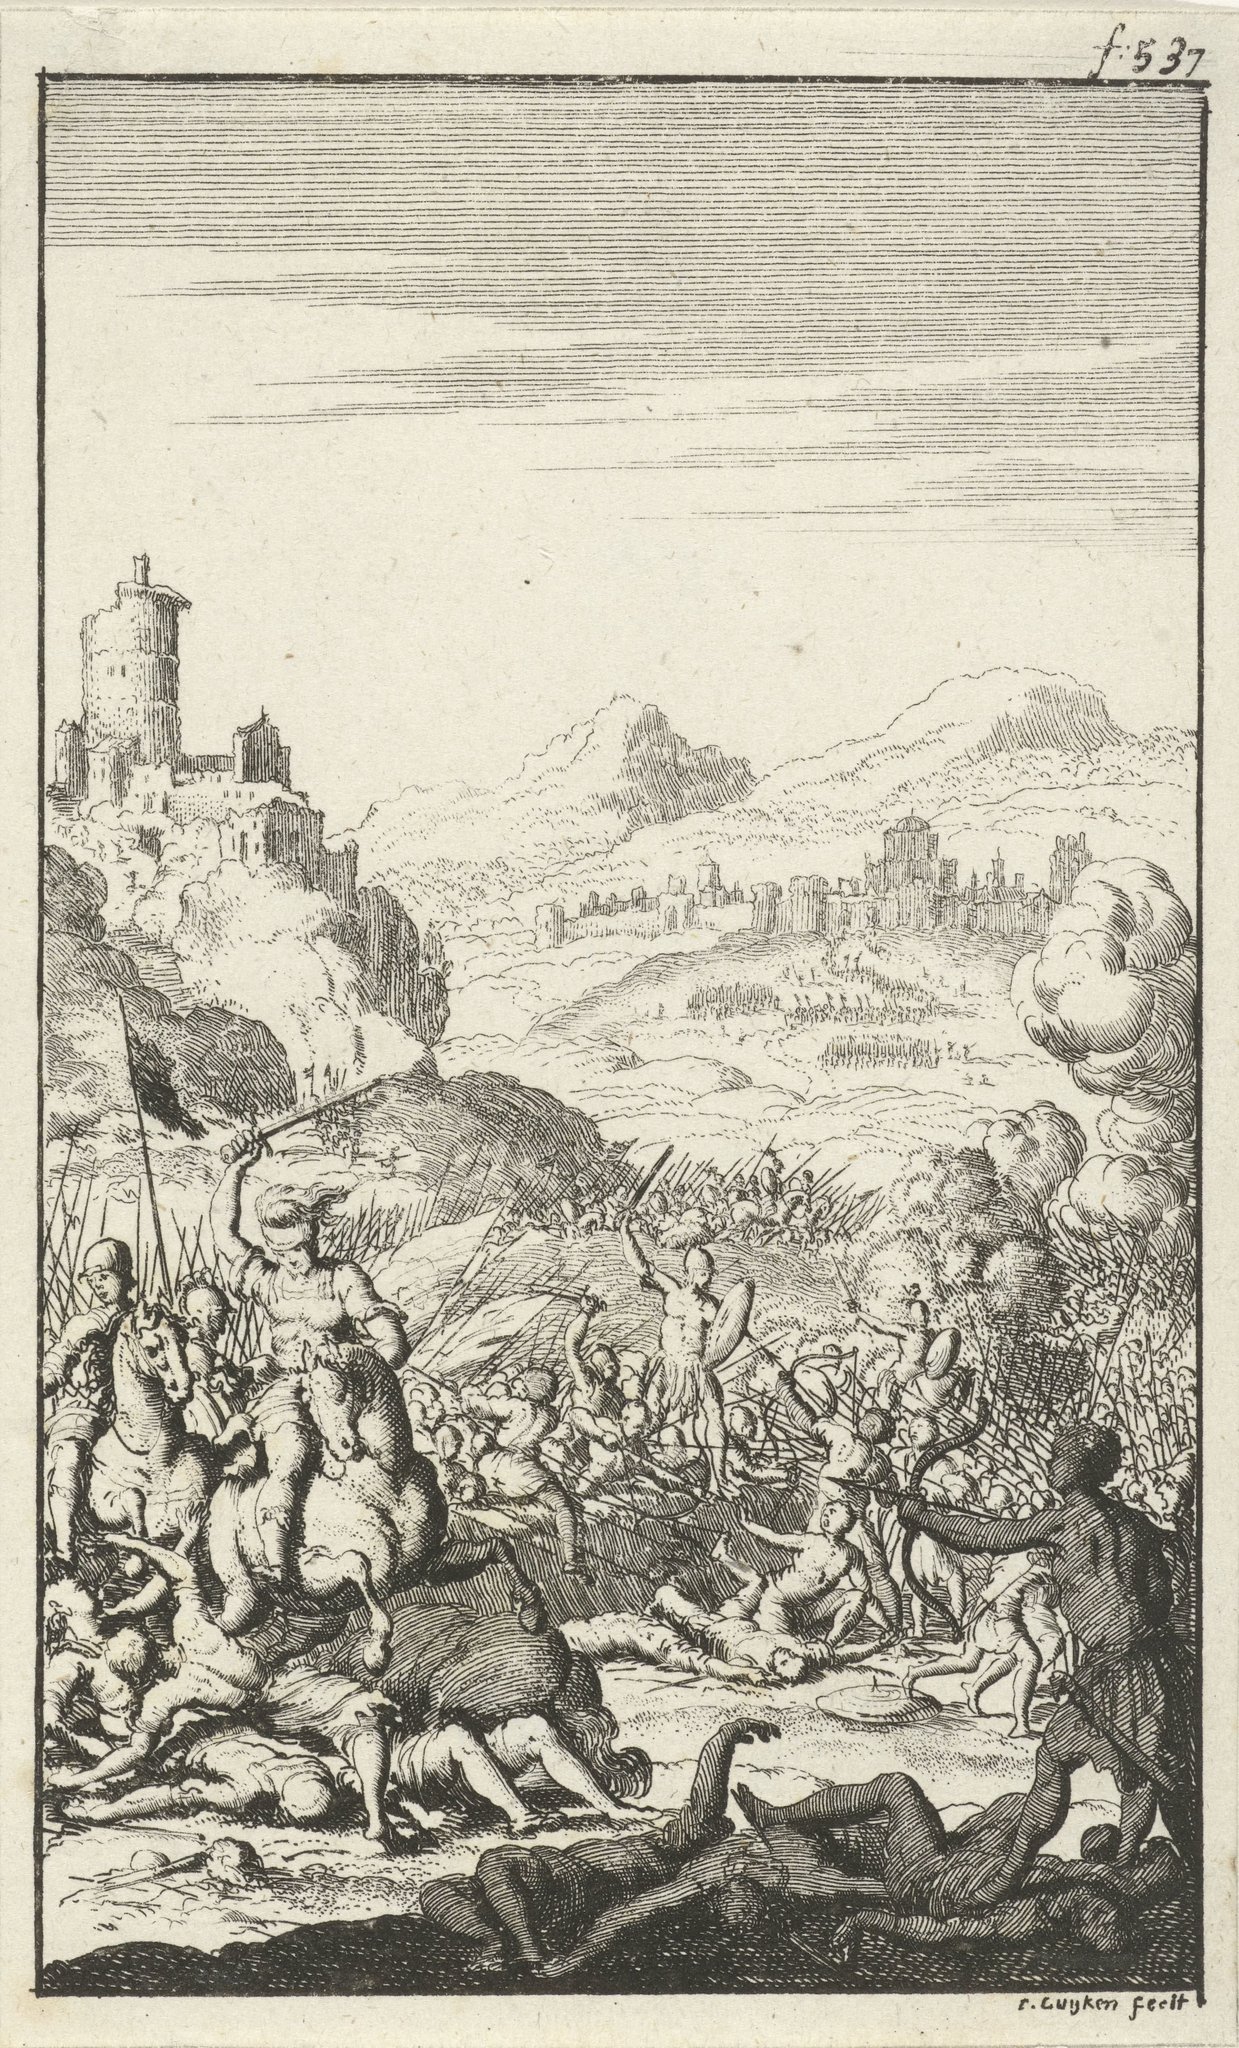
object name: print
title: Strijd tussen de legers van Poliarchus en Ambiodorix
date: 1681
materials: paper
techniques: etching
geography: amsterdam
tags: battle (+ land forces)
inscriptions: collector's mark: Lugt 2228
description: Illustratie opgenomen in het tweede deel van: Barclay, John. D'Argenis, 2 delen. Amsterdam: Jan Claesz ten Hoorn, 1680-1681.